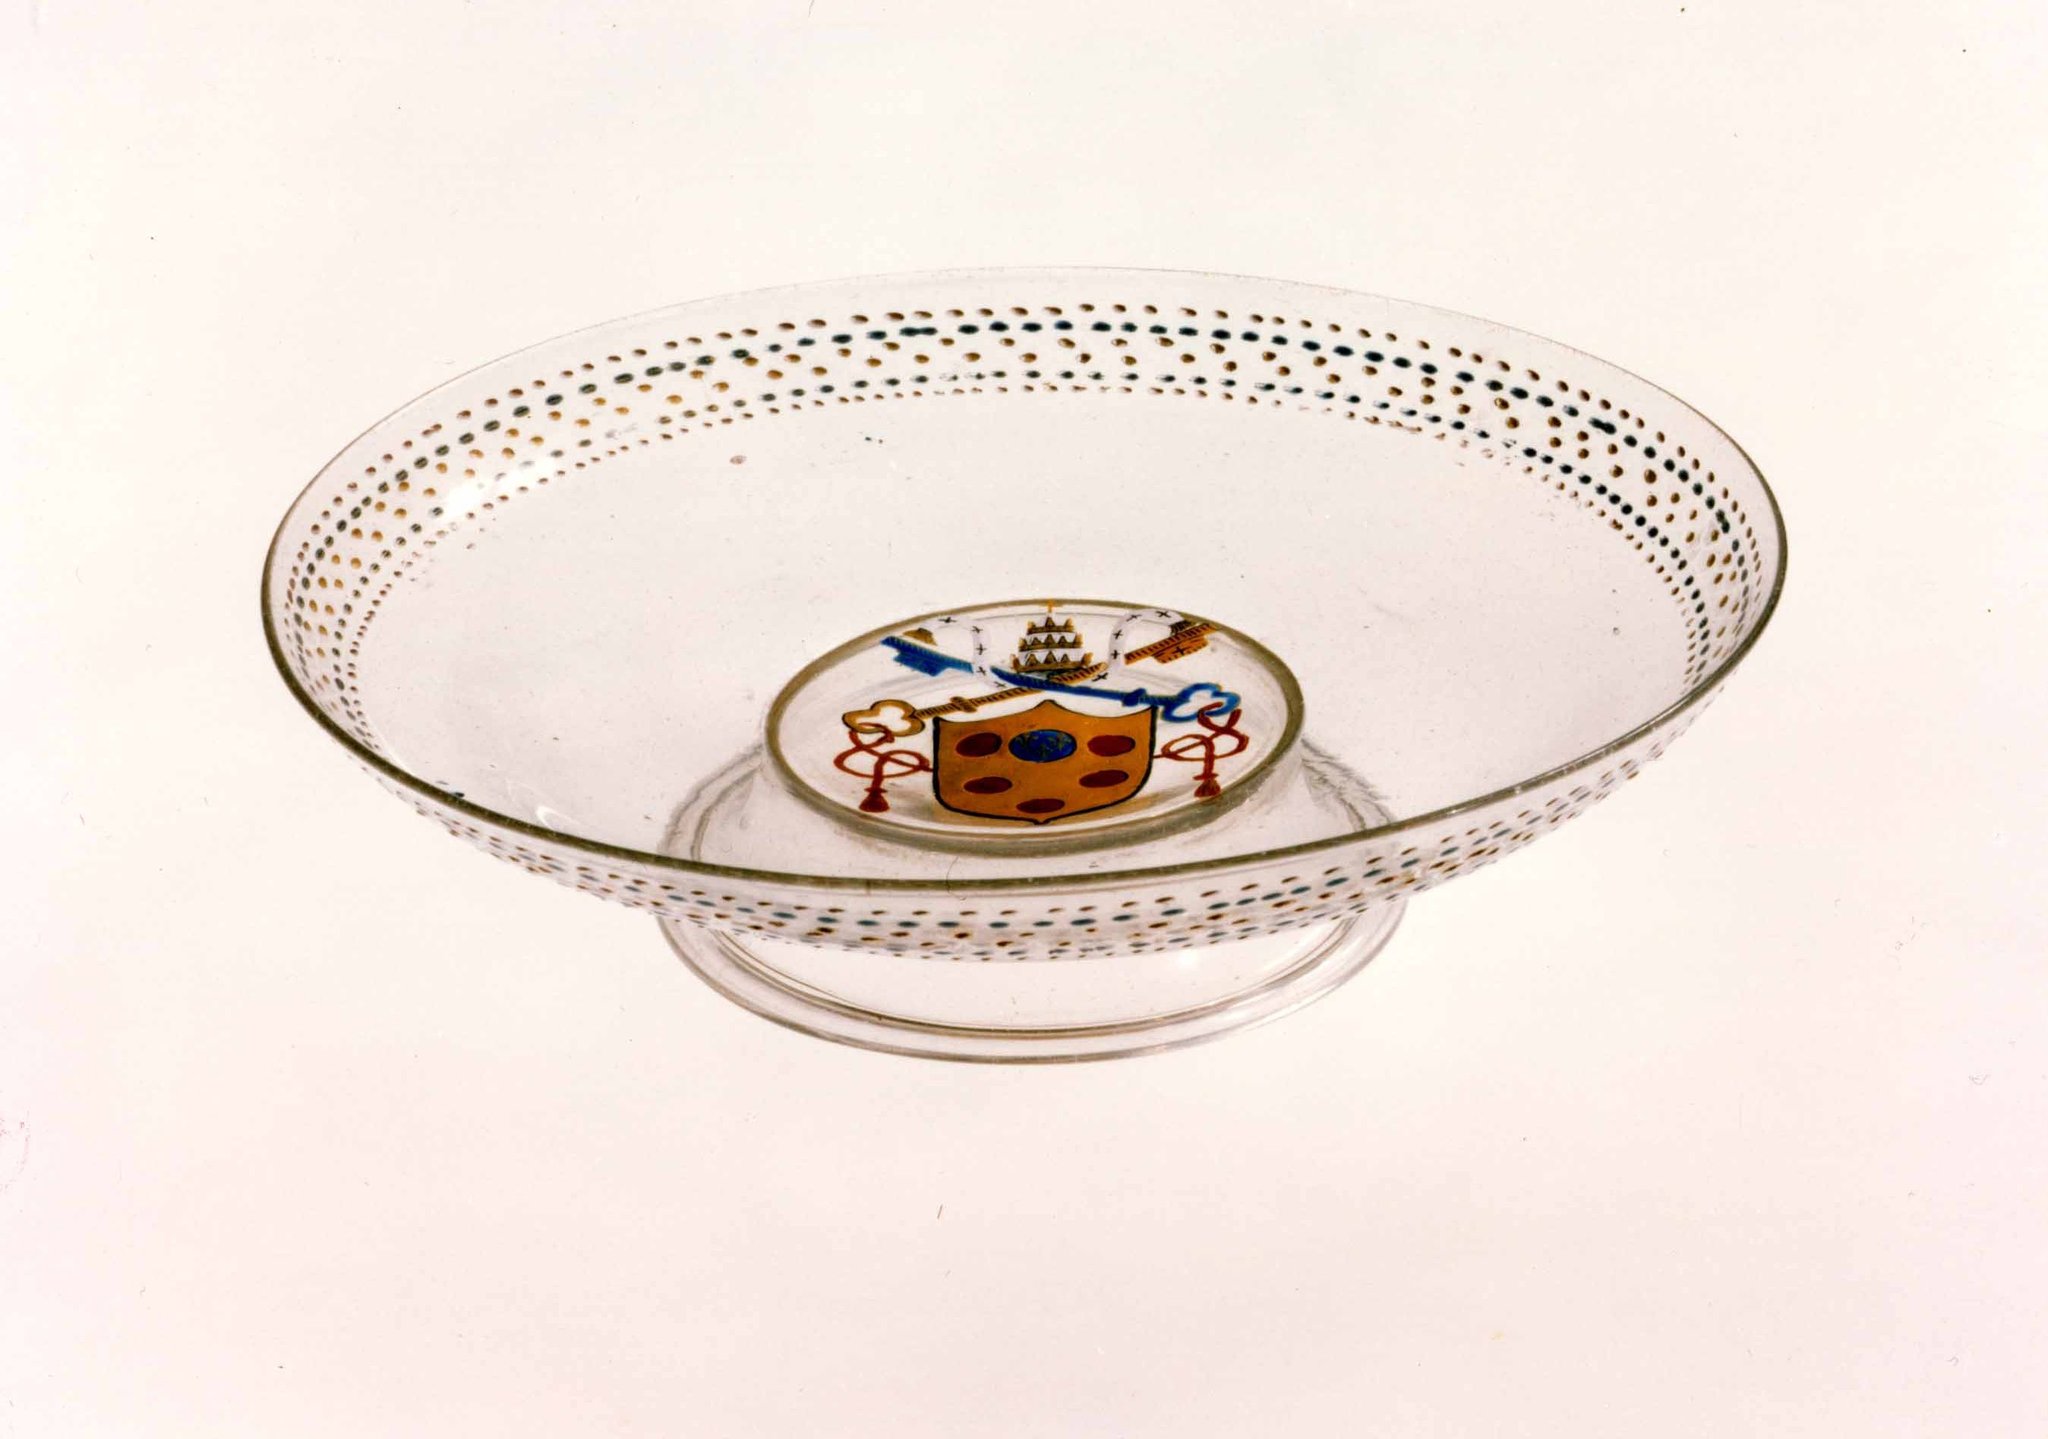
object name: tazza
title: Armorial tazza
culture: italian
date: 1513-1534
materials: gilt, glass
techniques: glassblowing, enamel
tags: coat of arms